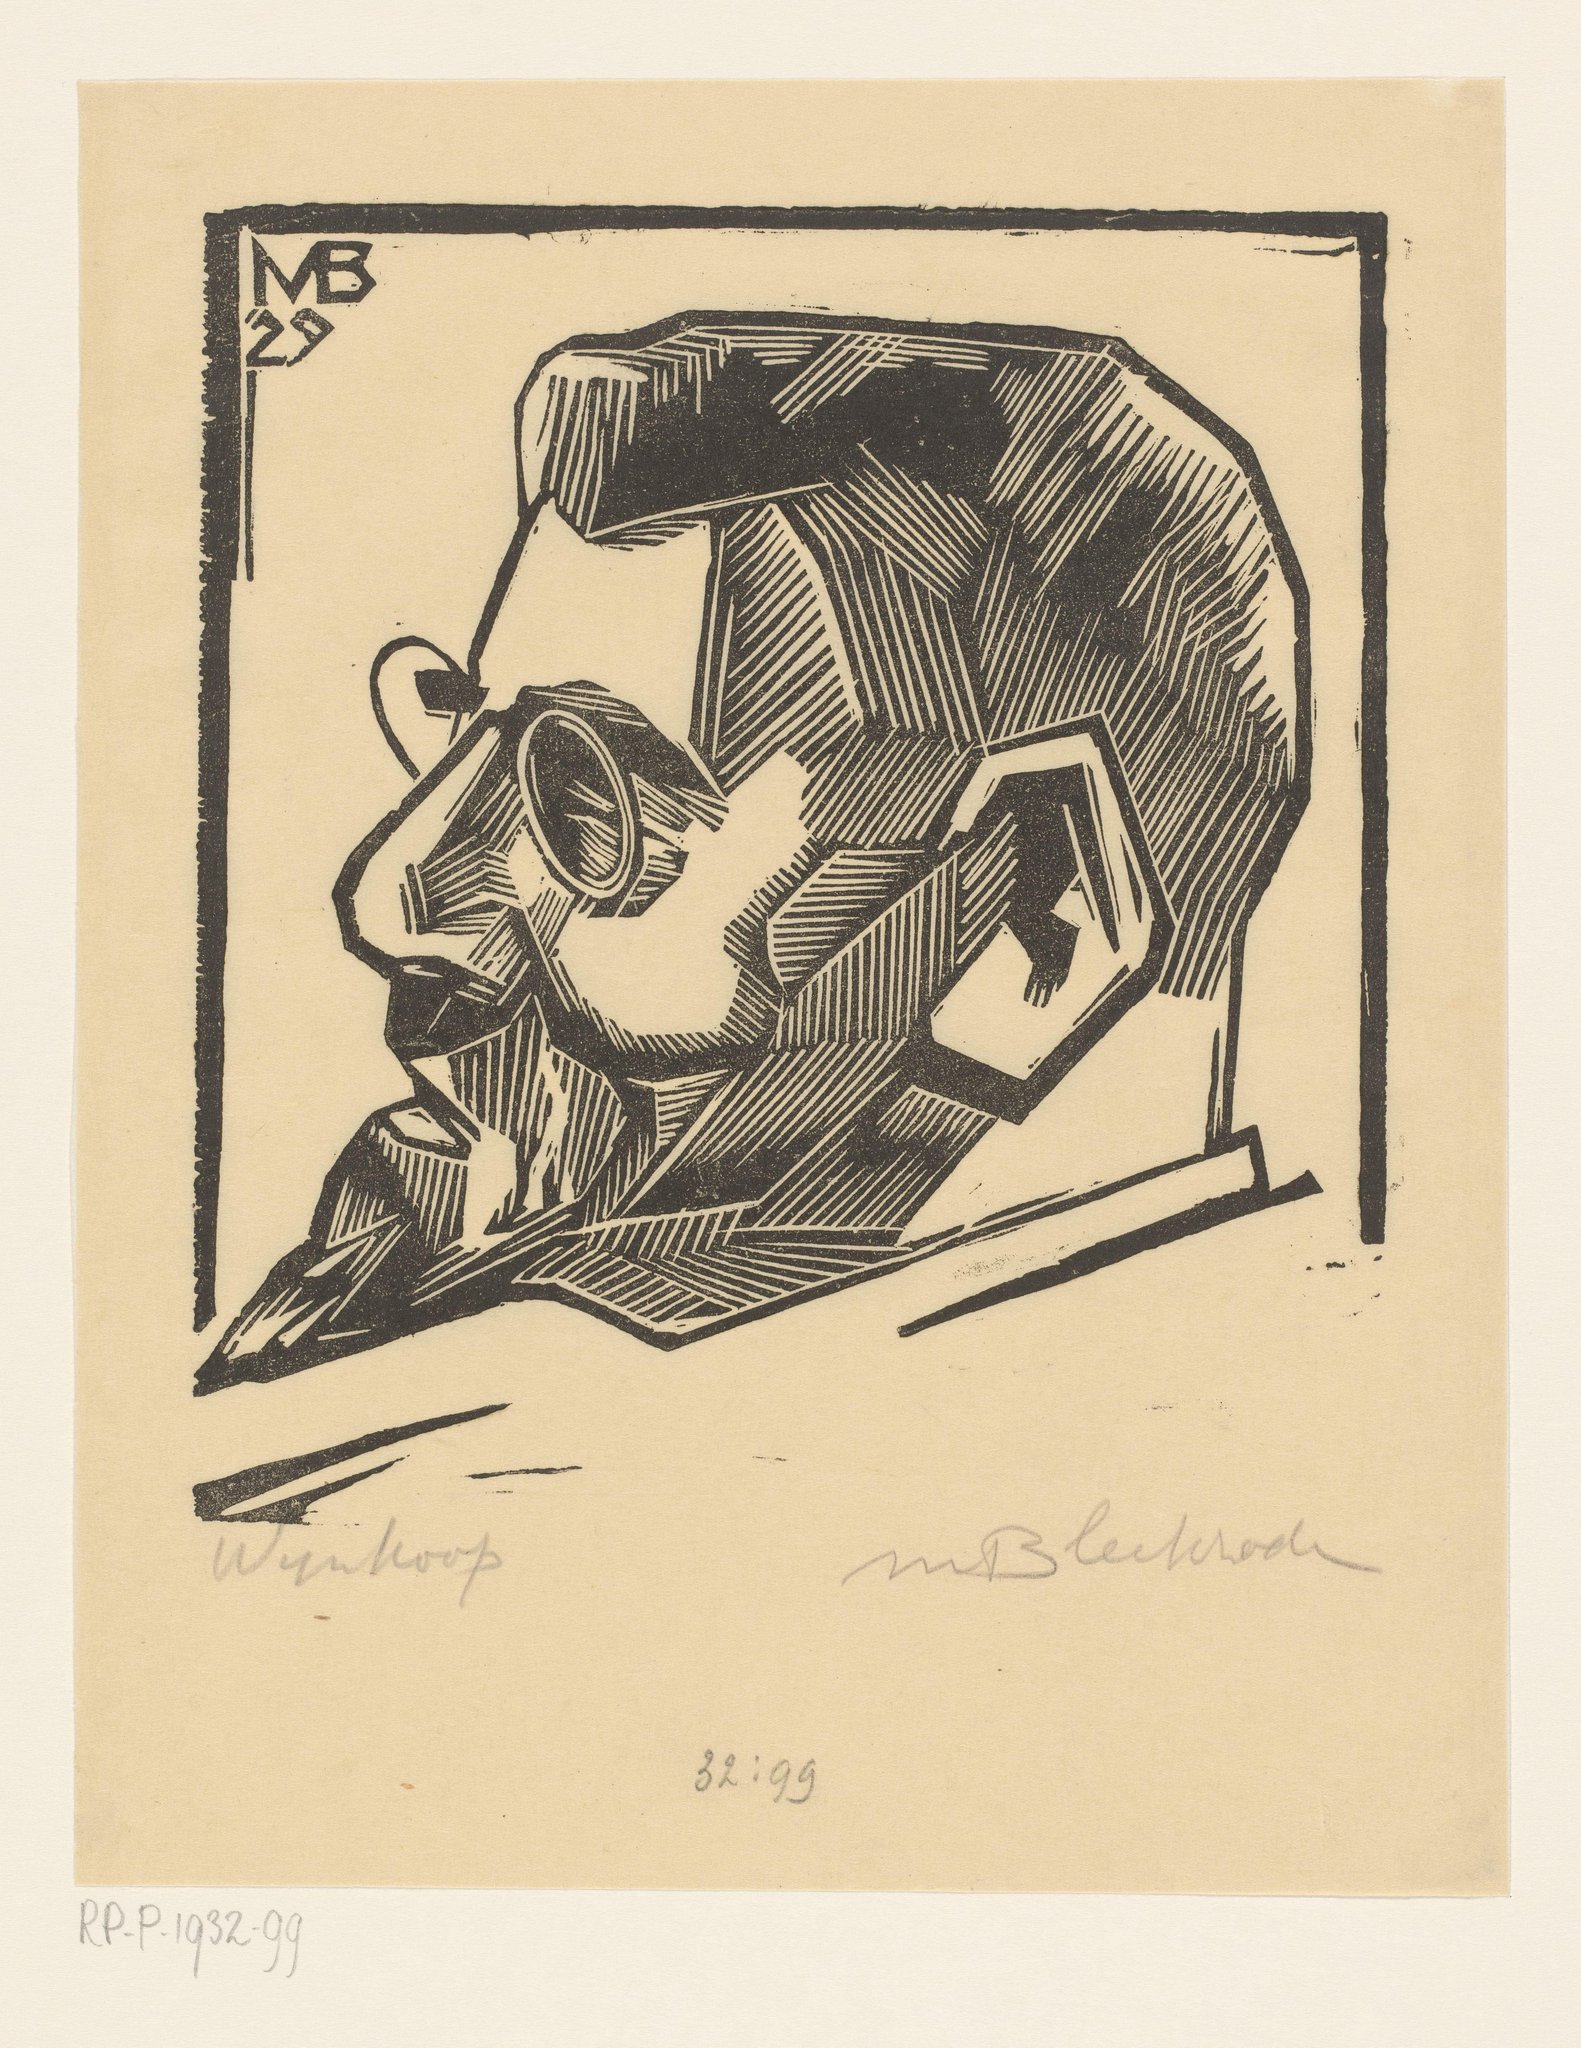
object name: print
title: Portret van David Wijnkoop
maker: meijer bleekrode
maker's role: draughtsman, painter, print maker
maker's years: 1896-1943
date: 1929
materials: paper, ink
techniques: woodcut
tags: politician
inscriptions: monogram and date: ‘MB '29’, collector's mark: Lugt 2228, signature: ‘MBleekrode’, title: ‘Wijnkoop’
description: Kop van een man met een puntbaard en een bril, en profil, gestileerd weergegeven.